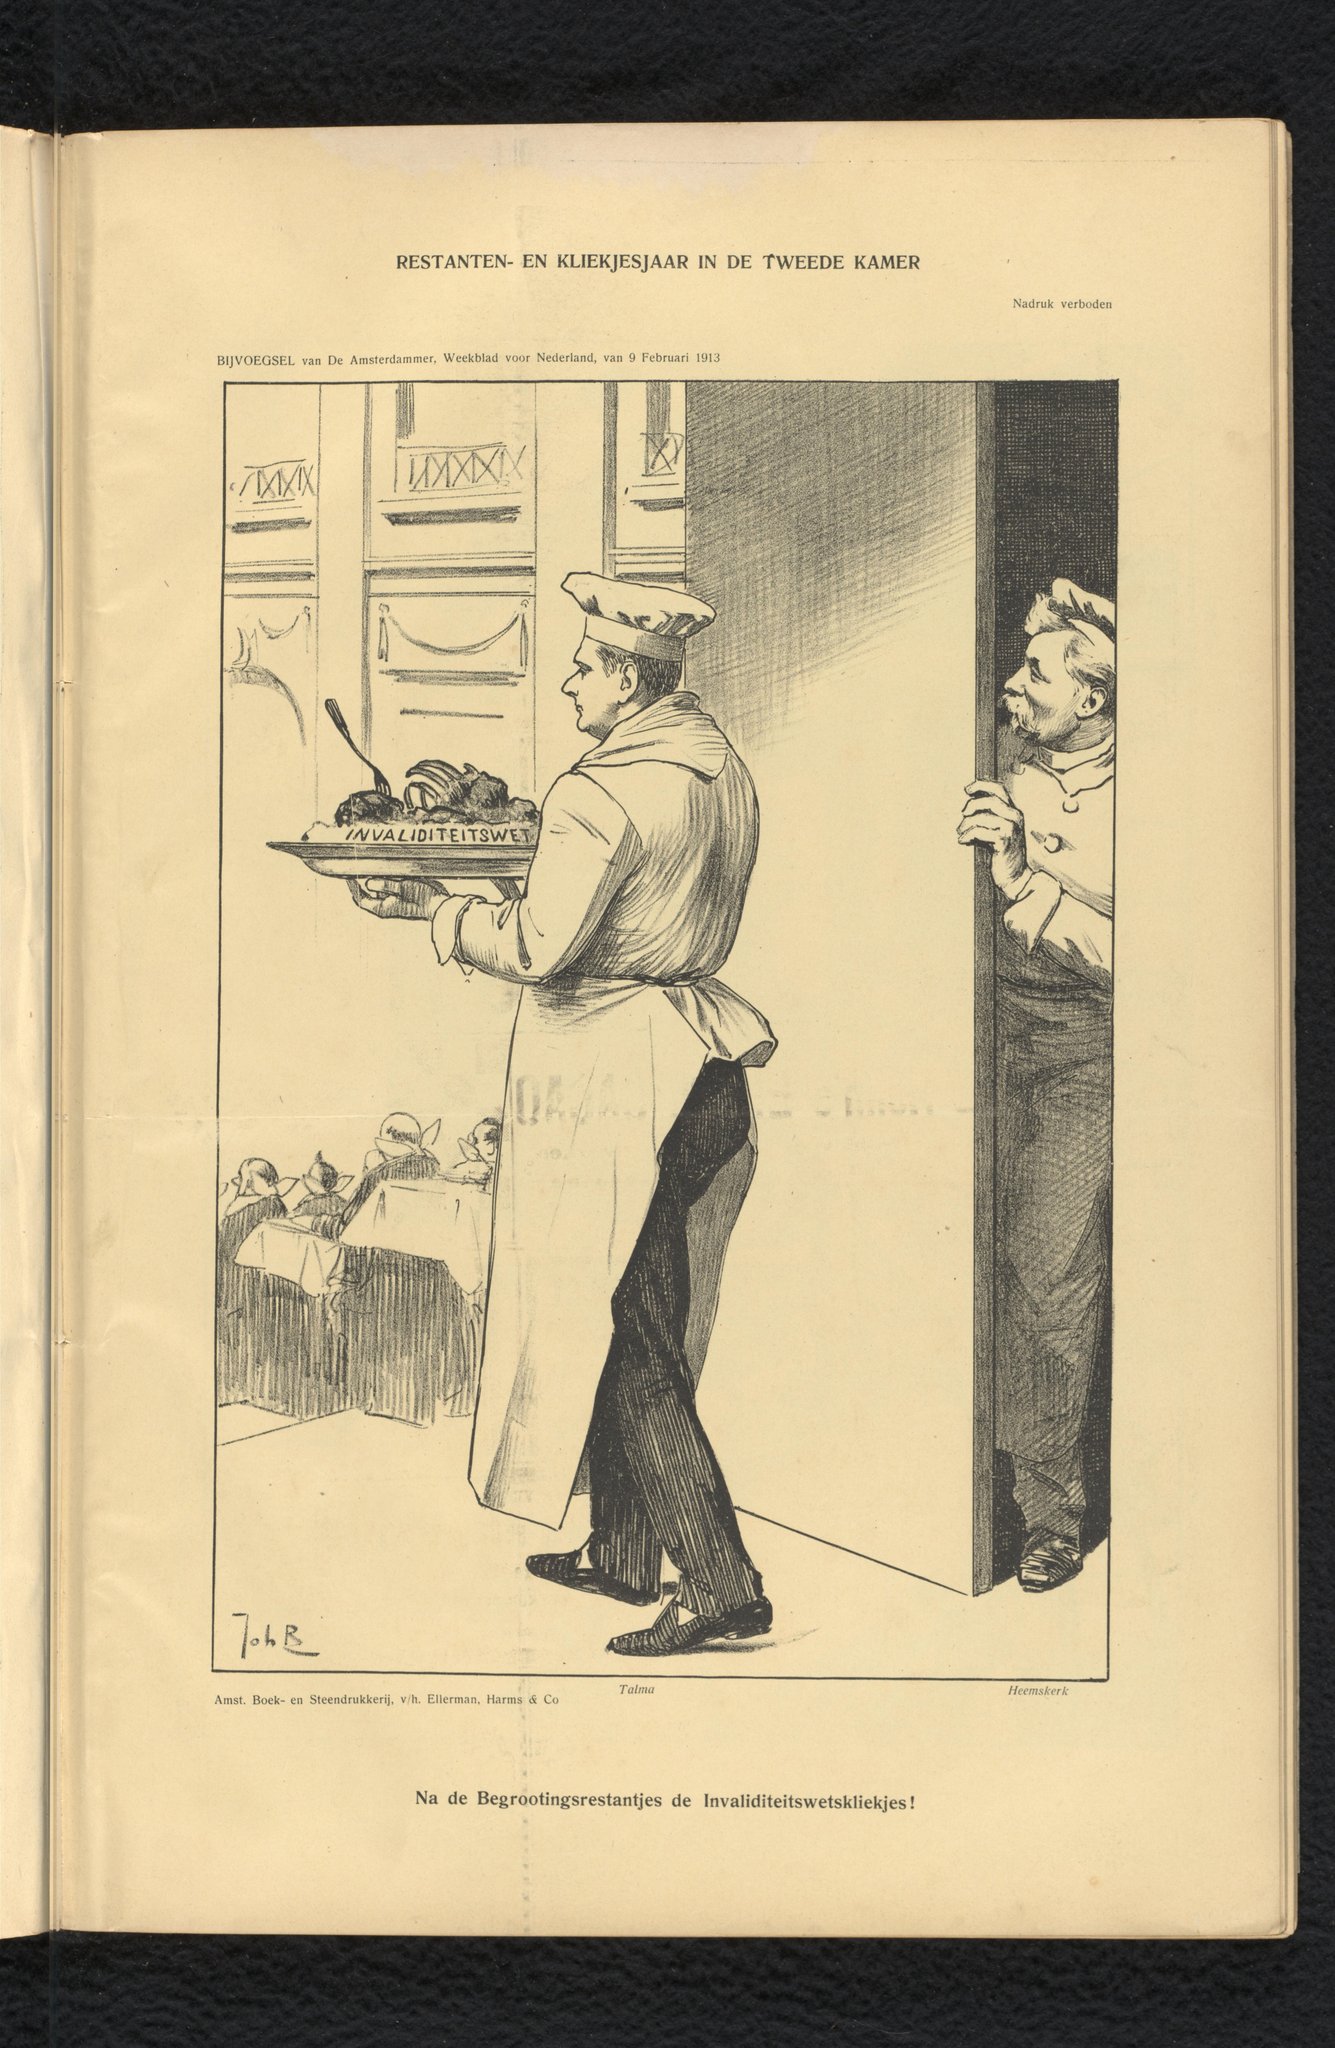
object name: cartoon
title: Restanten- en kliekjesjaar in de Tweede Kamer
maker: johan braakensiek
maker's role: draughtsman, print maker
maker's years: 1858-1940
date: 1913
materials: paper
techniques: lithograph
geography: netherlands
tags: amsterdam, utrecht, restaurant (+ waiter, waitress, etc.), lower house, parliament, chamber, political caricatures and satires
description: Premier Heemskerk als kok stuurt minister Syb Talma als ober de Tweede Kamer in om restjes 'invaliditeitswet' uit te serveren.